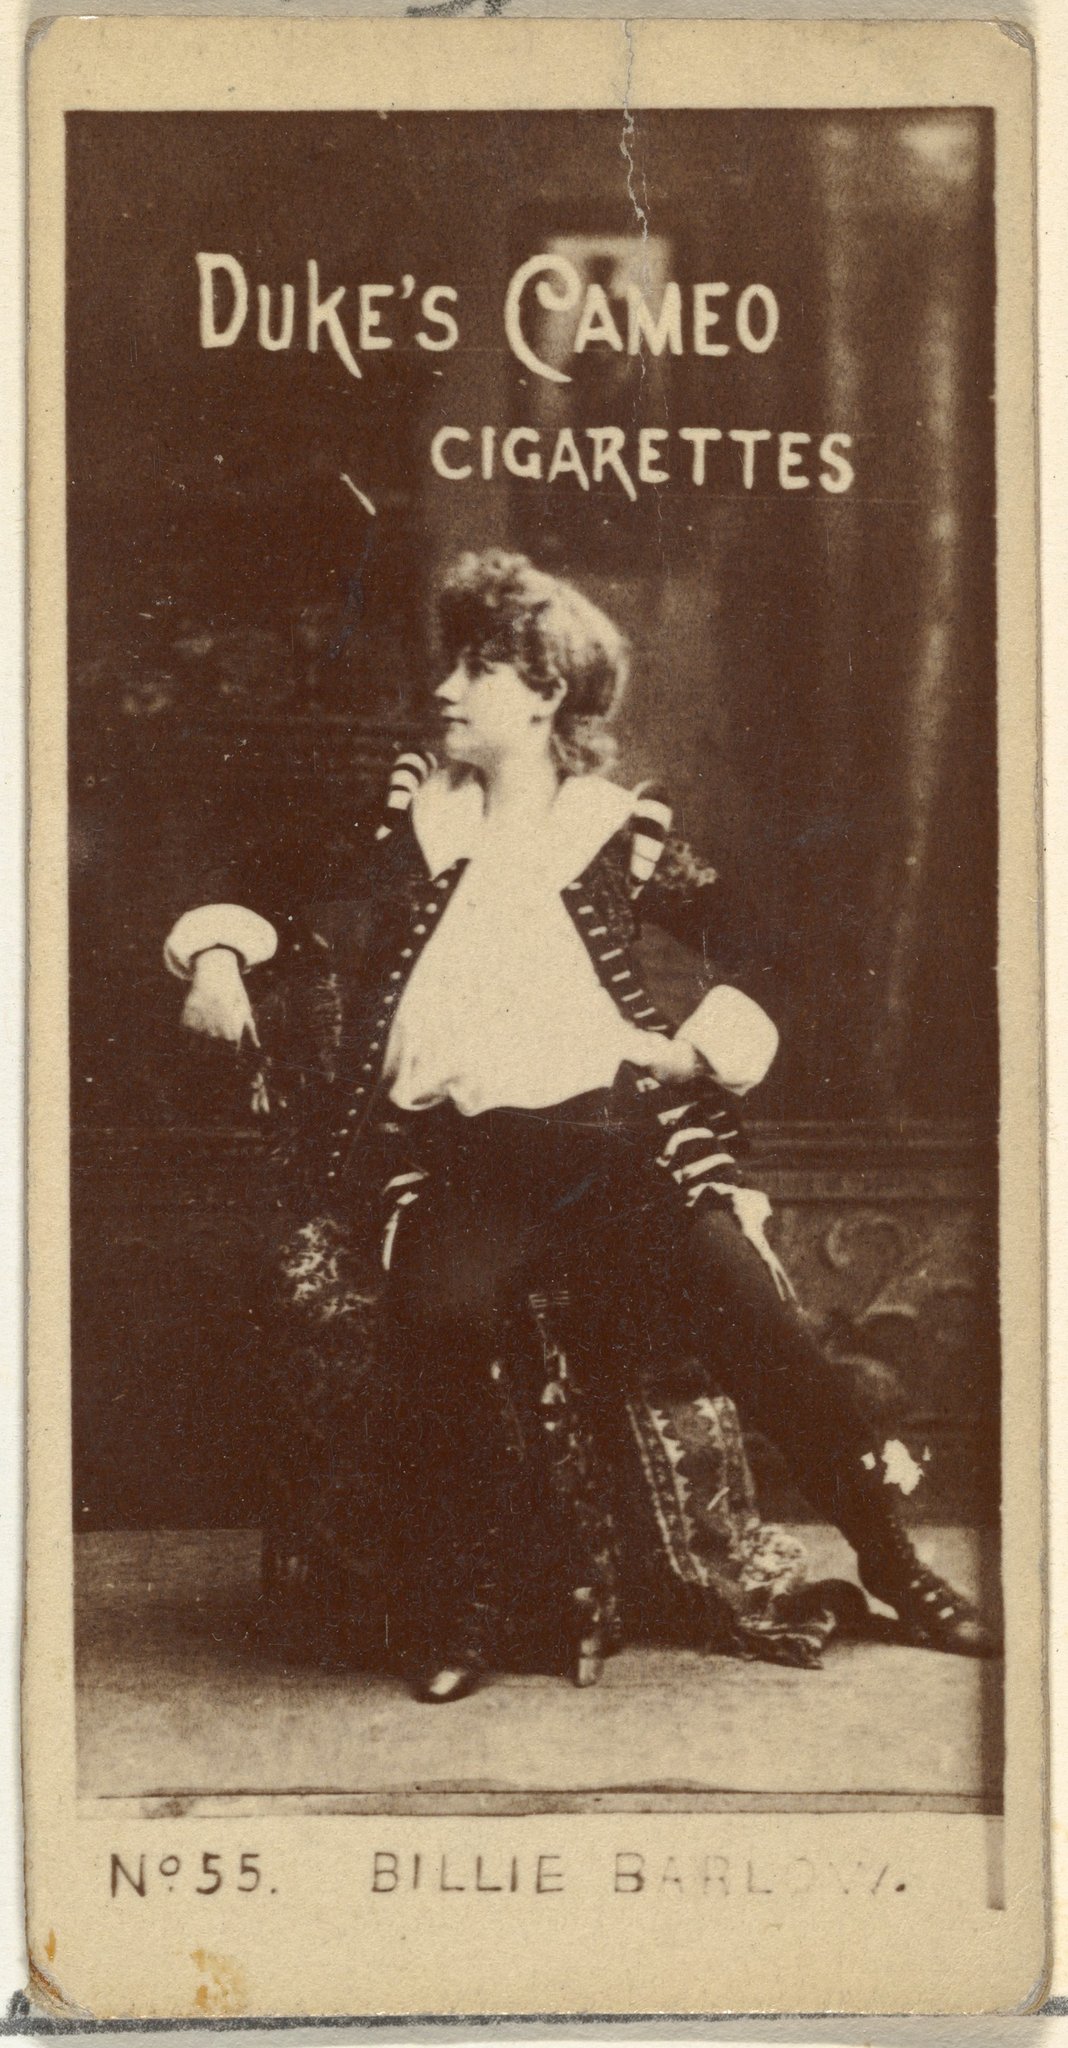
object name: photograph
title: Card Number 55, Billie Barlow, from the Actors and Actresses series (N145-4) issued by Duke Sons & Co. to promote Cameo Cigarettes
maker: w. duke, sons & co.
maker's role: publisher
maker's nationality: american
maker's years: 1870-1920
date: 1880-1889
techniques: albumen silver print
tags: women,actresses